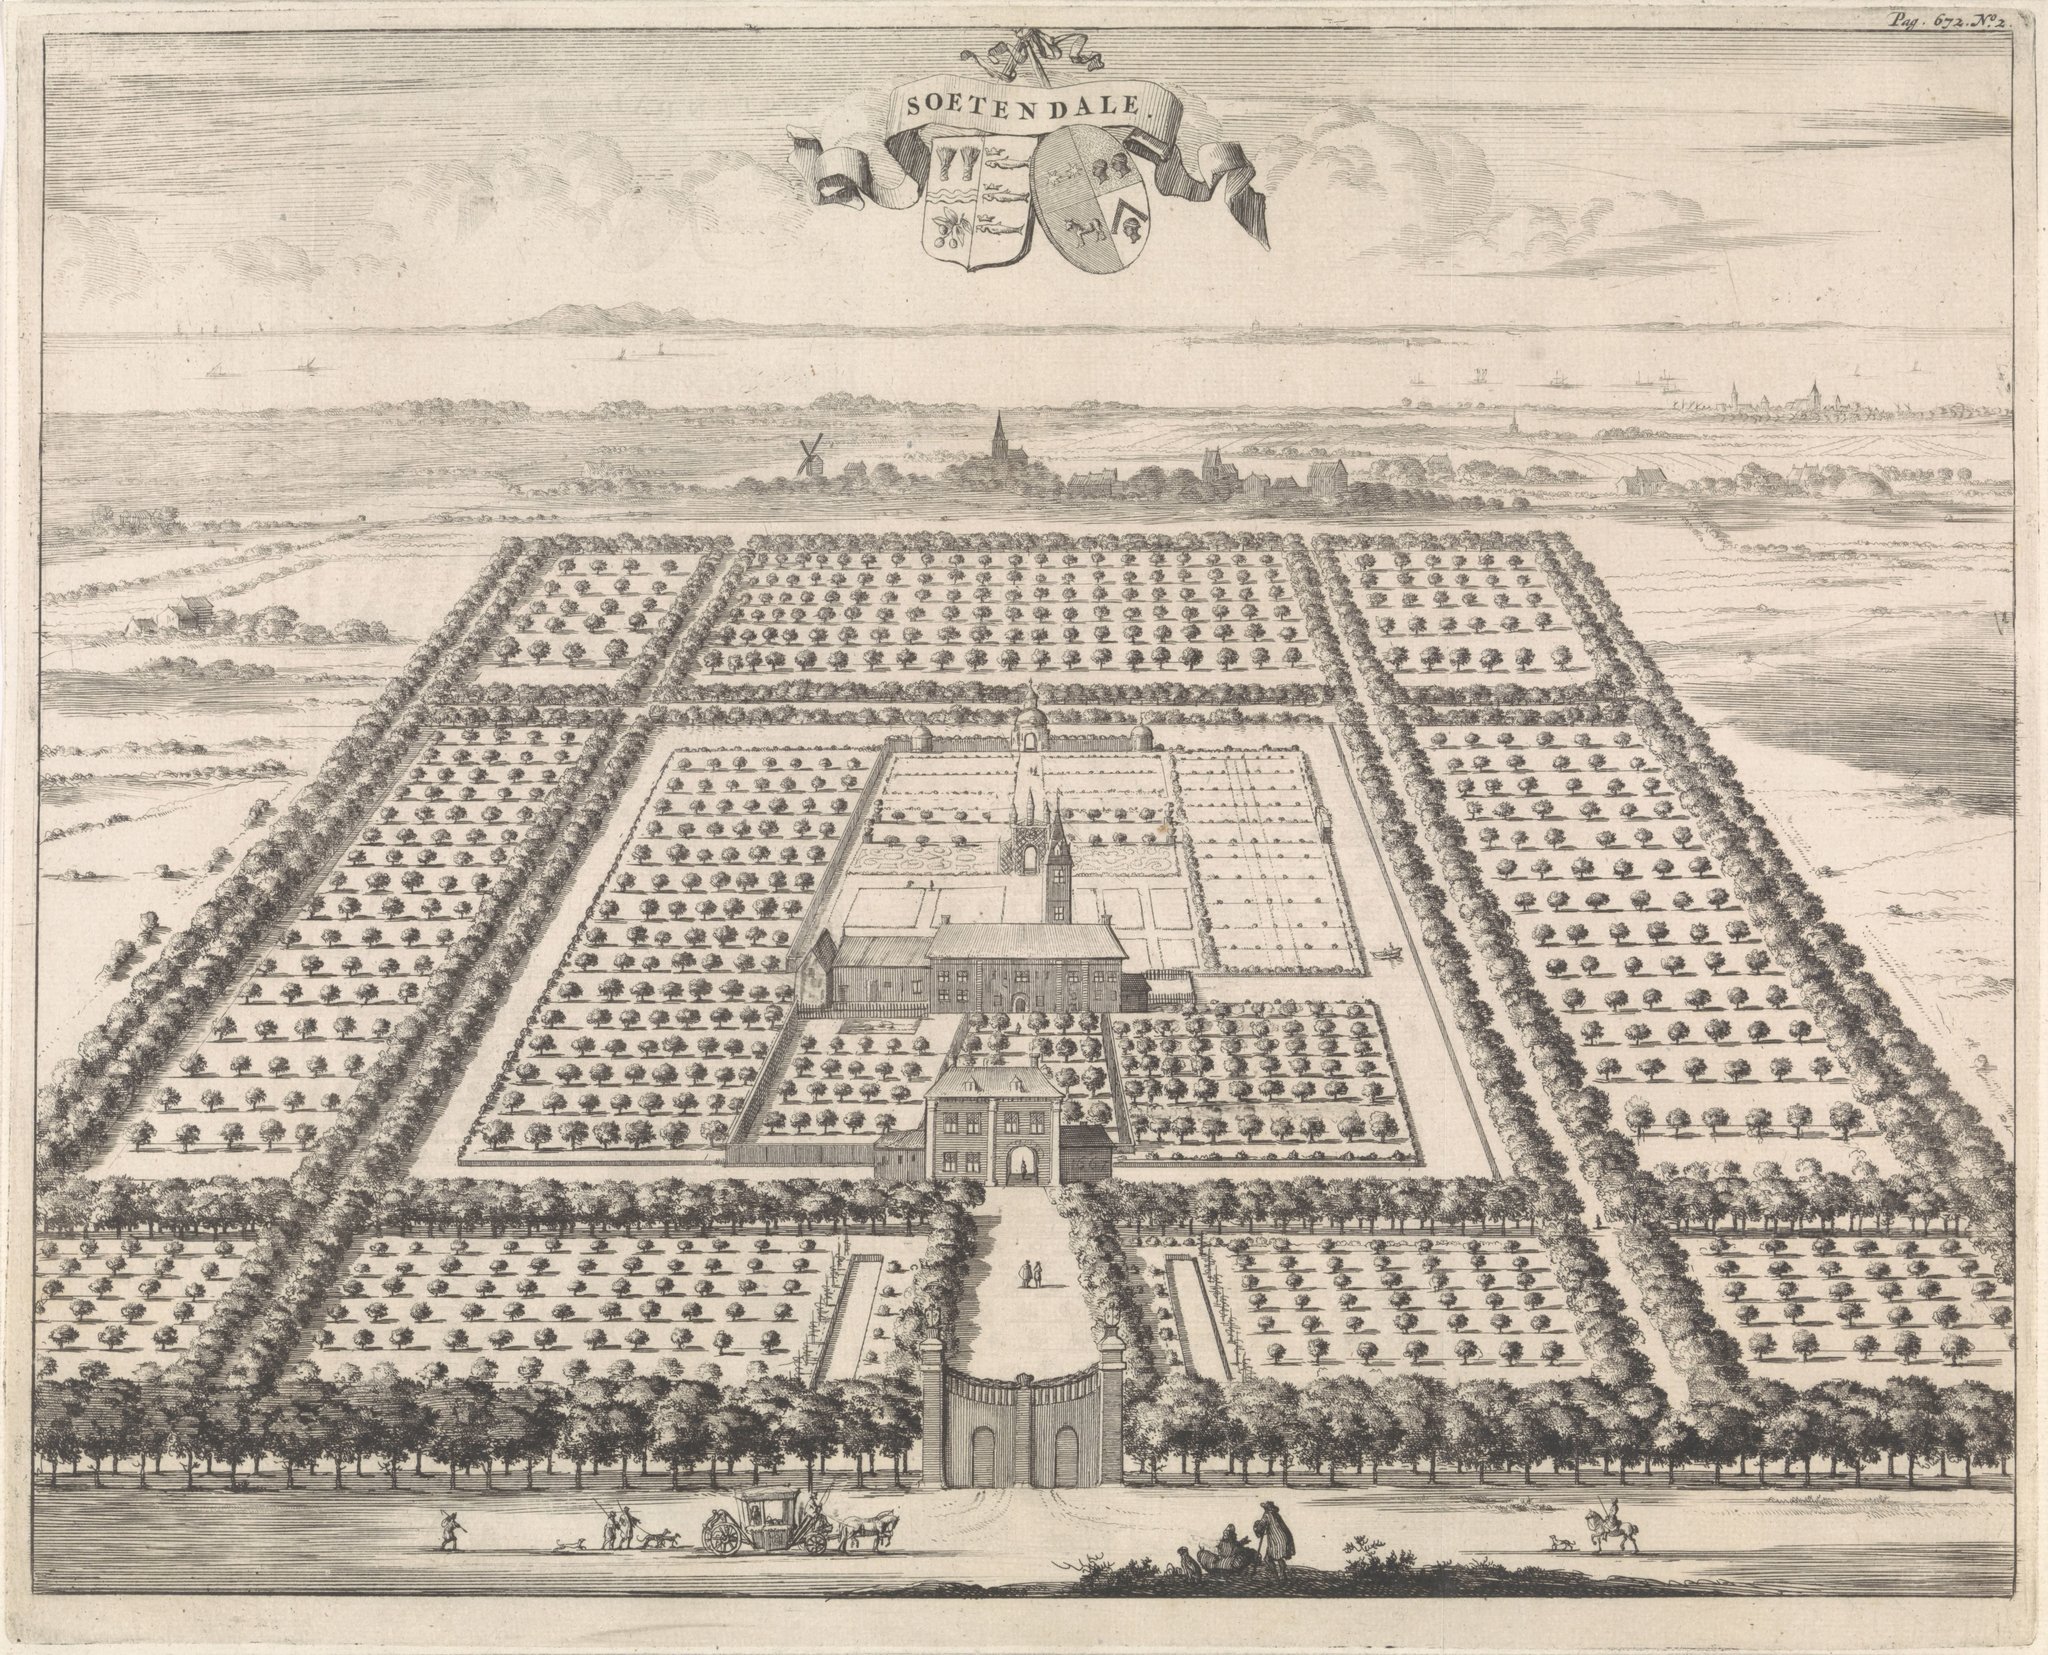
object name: print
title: Soetendale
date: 1696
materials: paper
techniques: engraving, etching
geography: amsterdam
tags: prospect of village, silhouette of village, garden, gate, entrance, orchard, armorial bearing, heraldry, country-house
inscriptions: collector's mark: Lugt 2228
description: Gezicht op de buitenplaats Soetendale, gelegen tussen Grijps- en Serooskerke op Walcheren, in vogelvluchtperspectief. Boven in het midden een banderol met de titel en daaronder links het wapen van eigenaar Johan Steengracht en rechts dat van zijn echtgenote Barbara Veth. Rechtsboven gemerkt: Pag. 672. No. 2.